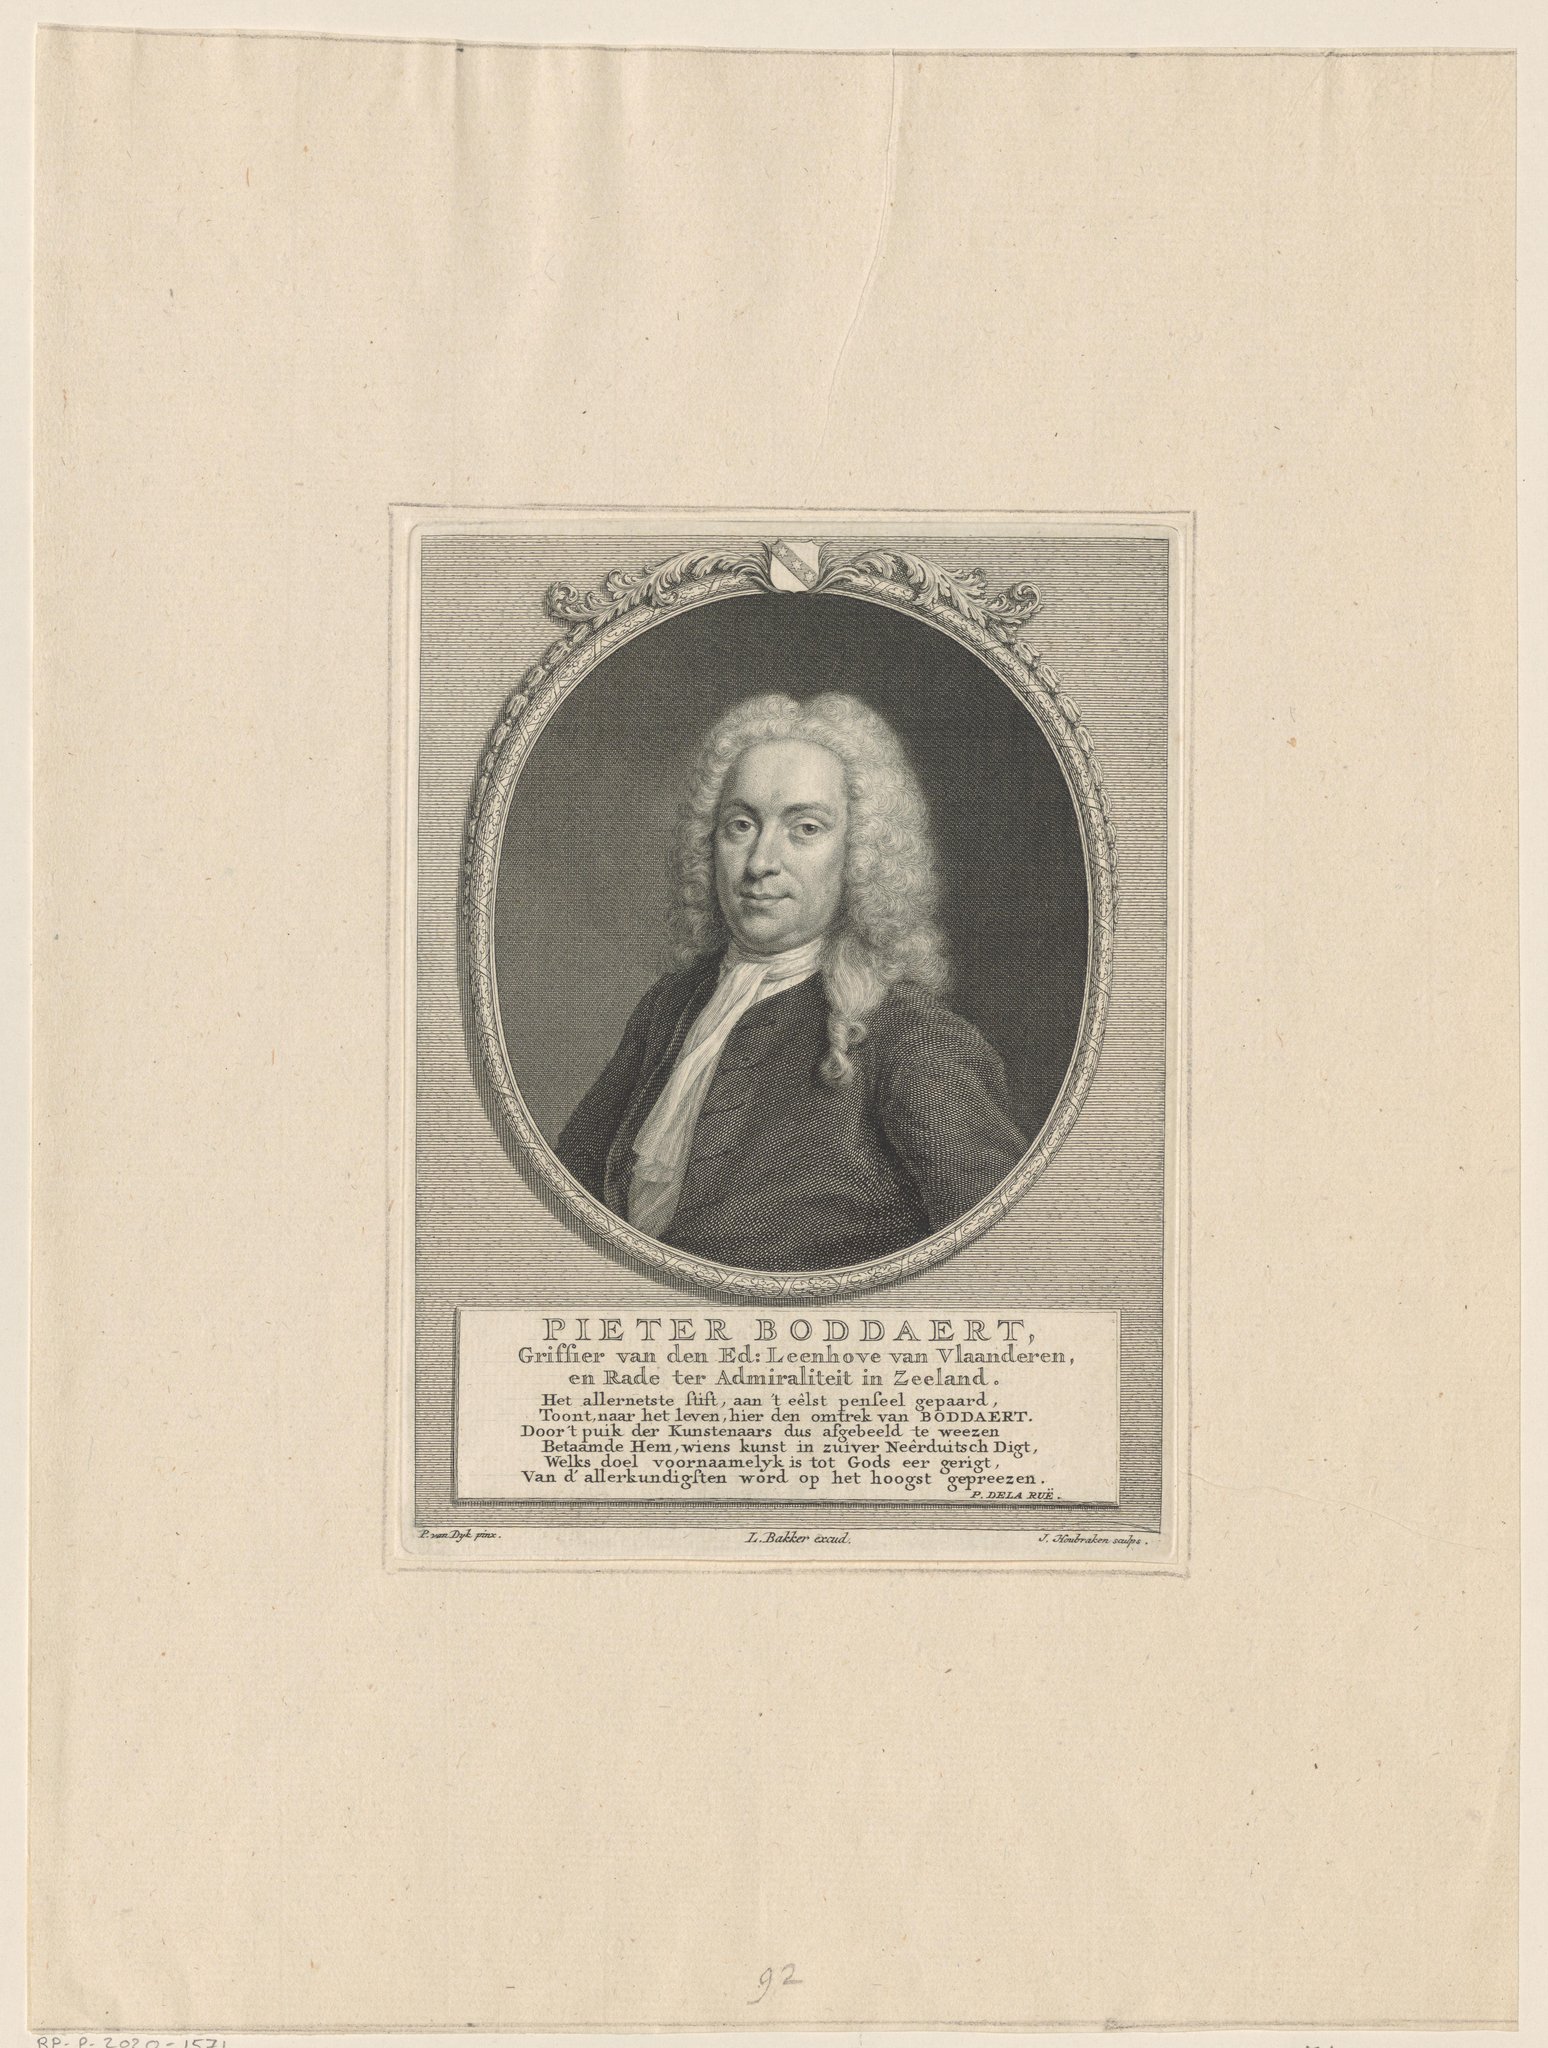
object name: print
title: Portret van Pieter Boddaert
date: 1722-1757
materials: paper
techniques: engraving, etching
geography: middelburg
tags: pieter boddaert (1694-1760), historical persons, portrait of a writer, armorial bearing, heraldry